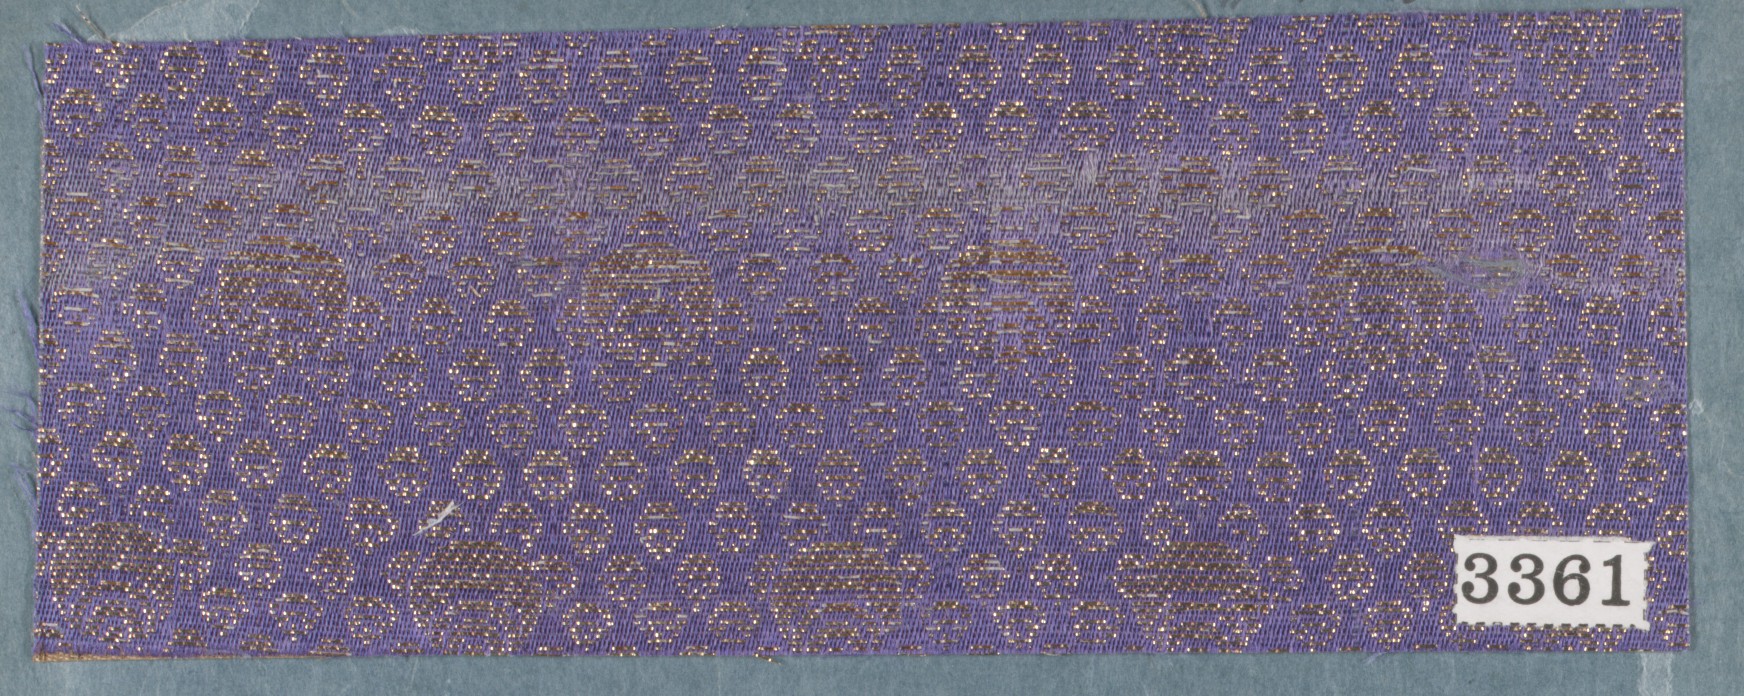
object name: textile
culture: japanese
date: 1801-1900